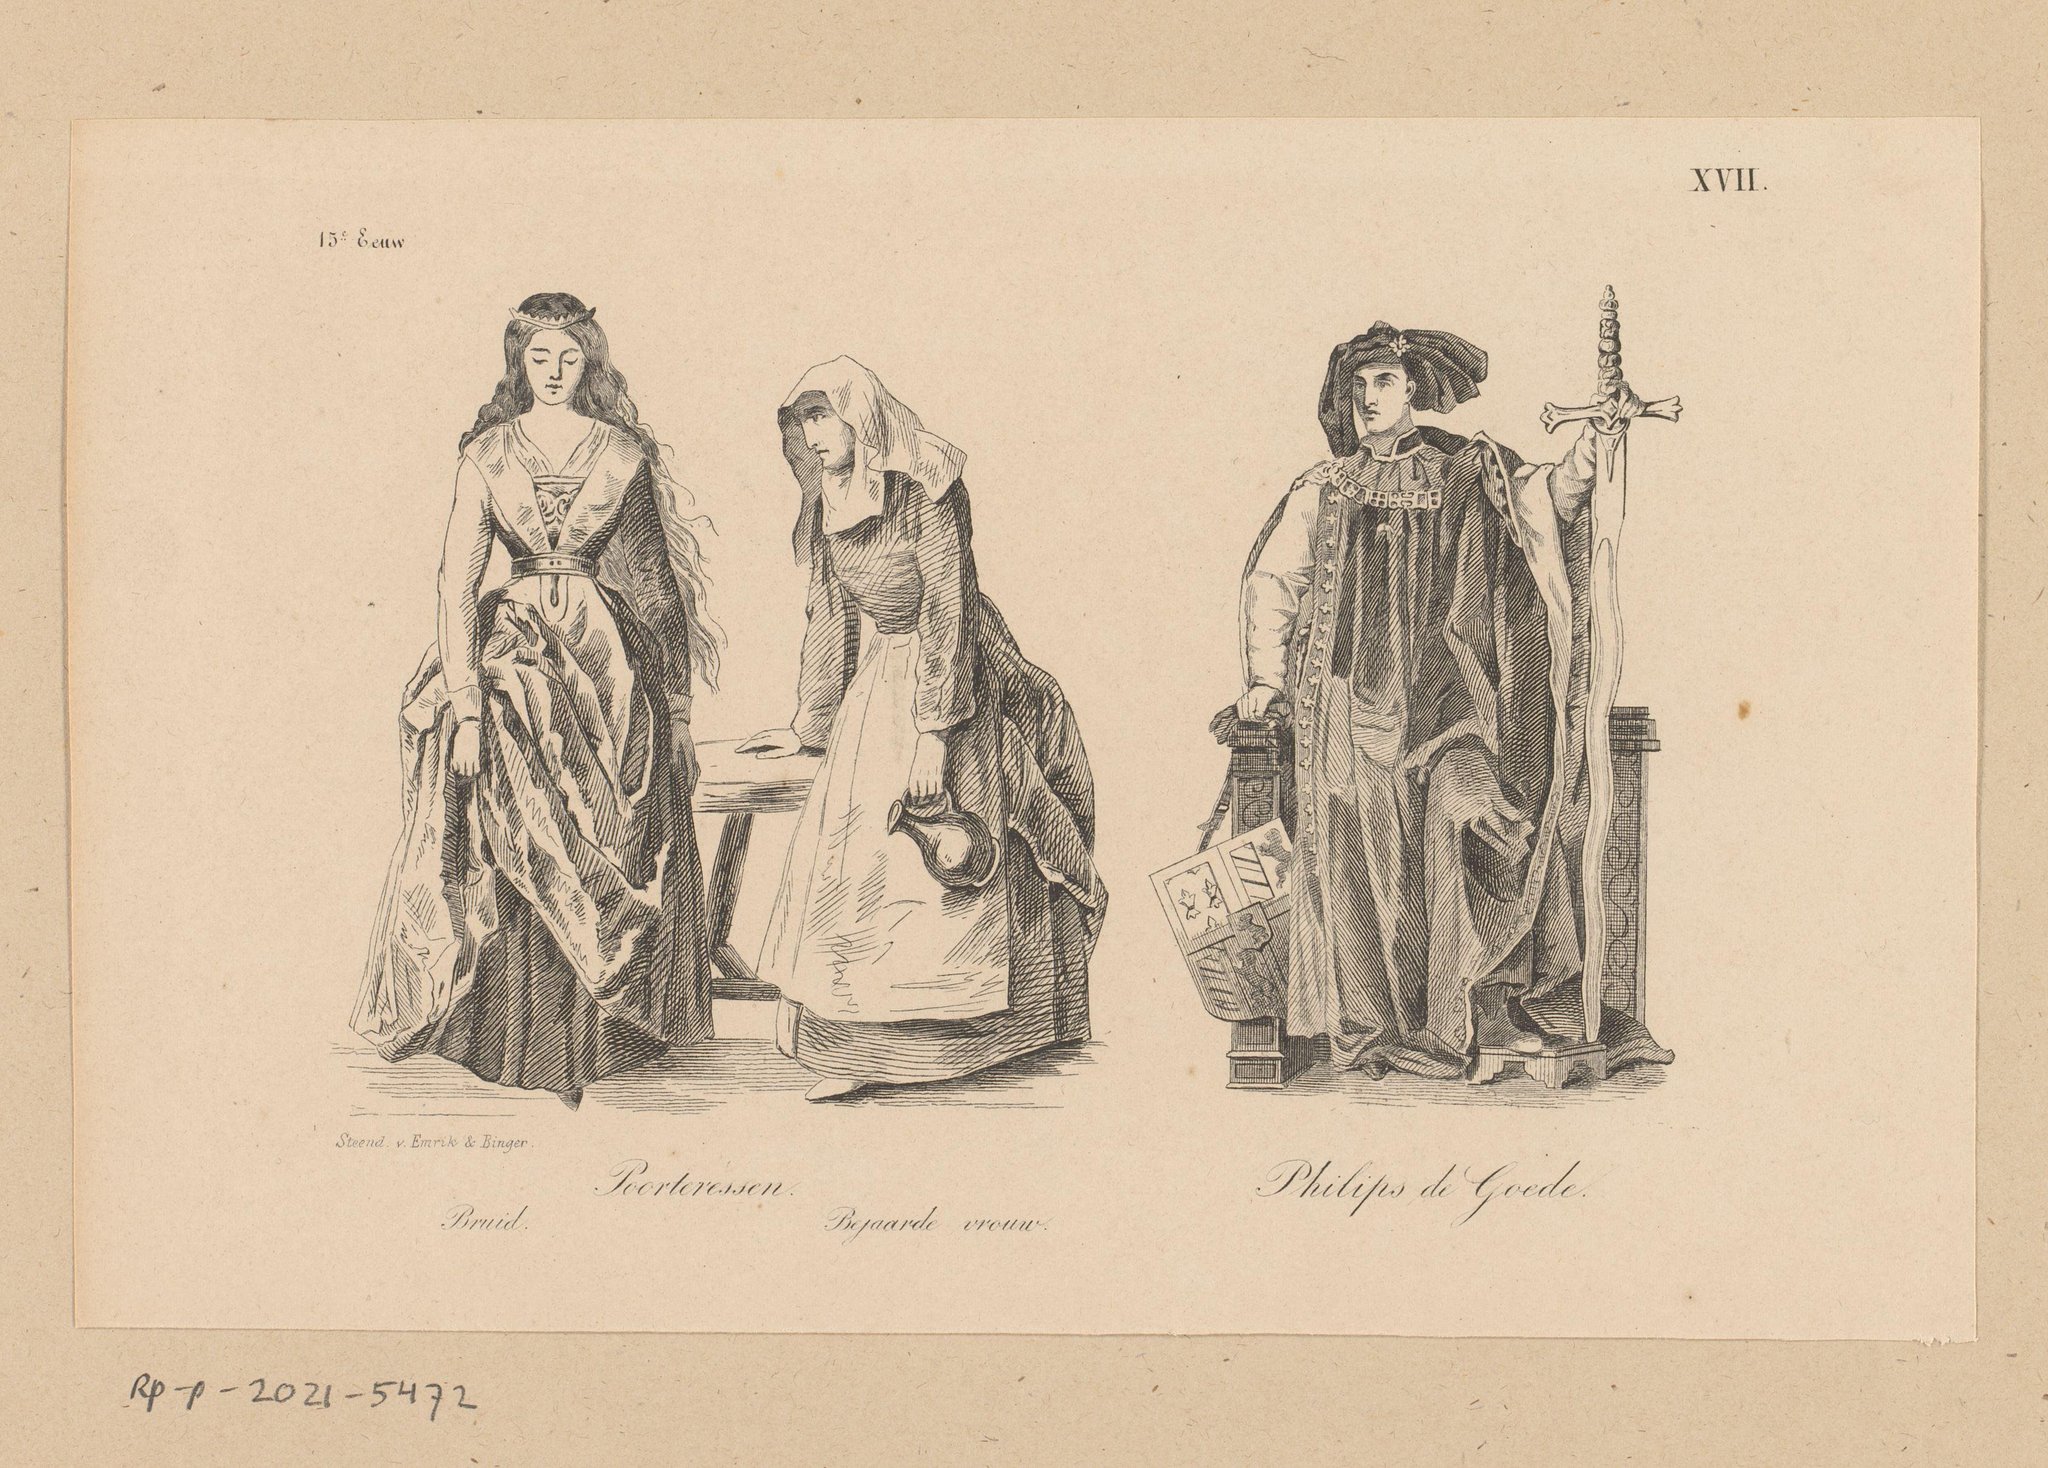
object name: book illustration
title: Poorteressen en Filips de Goede in kleding uit de vijftiende eeuw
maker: Anonymous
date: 1857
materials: paper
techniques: lithograph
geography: netherlands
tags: bruges, philip iii the good, historical persons, hacking and thrusting weapons: sword, bride (in wedding-dress), clothes, costume, armorial bearing, heraldry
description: Prent waarschijnlijk uit: Hofdijk, Willem Jacob. Schets van de geschiedenis der Nederlanden. Amsterdam: Gebroeders Binger, 1857.